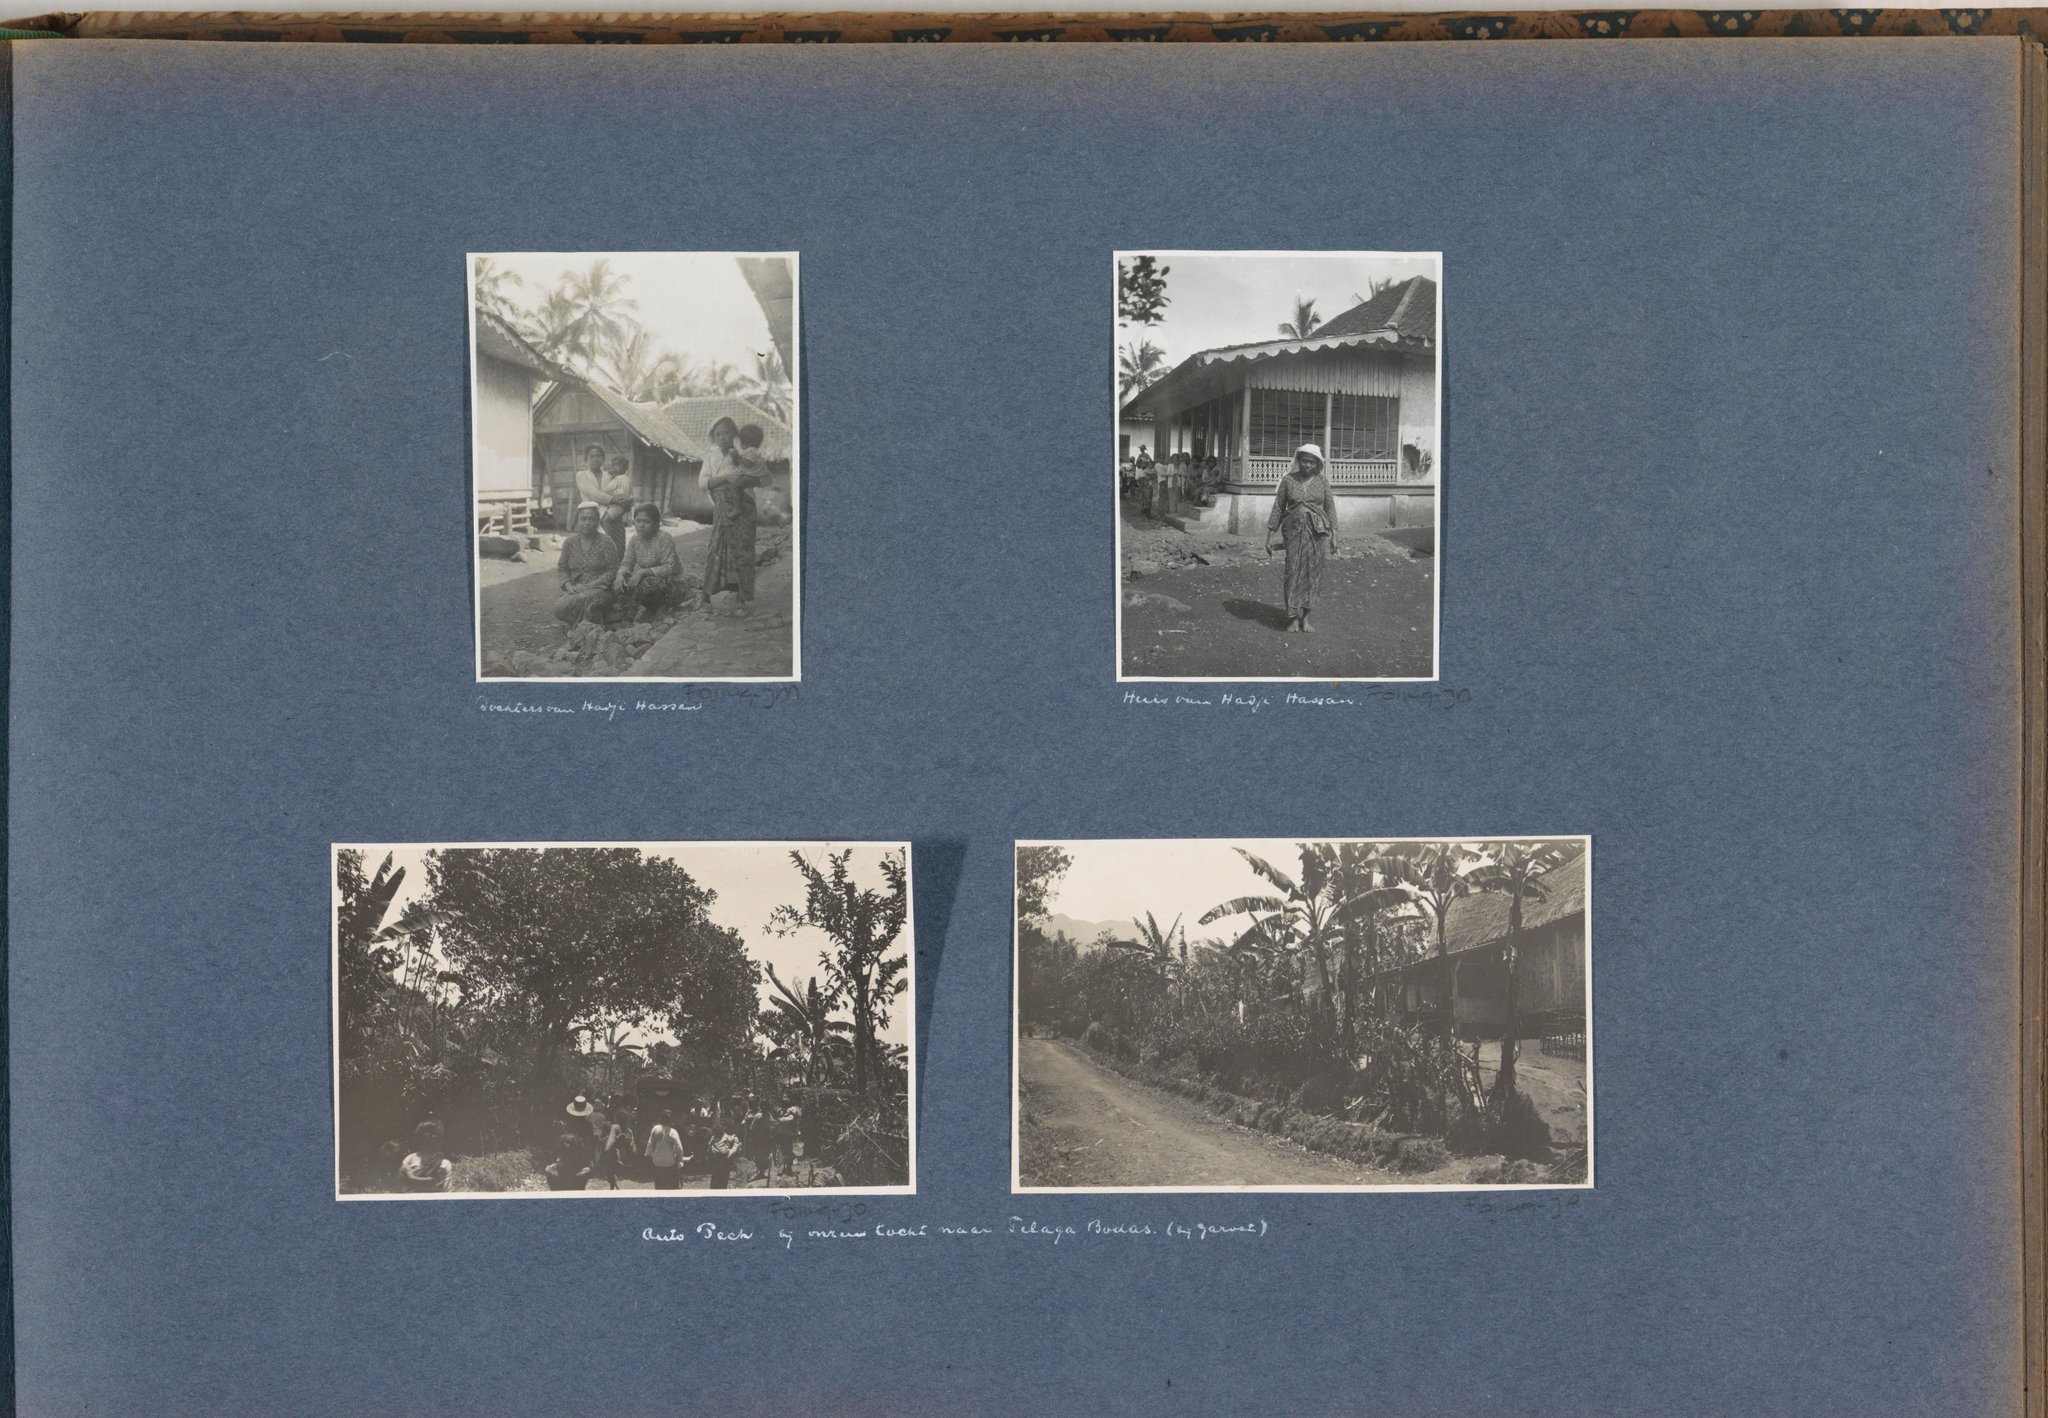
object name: photograph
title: Groepsportret van de dochters van Hadji Hassan op een erf (vermoedelijk) in Preanger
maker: Anonymous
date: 1900-1920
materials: paper, photographic support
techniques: gelatin silver print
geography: preanger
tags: mother and baby or young child, brothers or sisters (second degree family relationships)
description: Onderdeel van reisalbum met foto's van bedrijvigheid en bezienswaardigheden op Sumatra en Java en van de reis naar en van Nederlands-Indië.